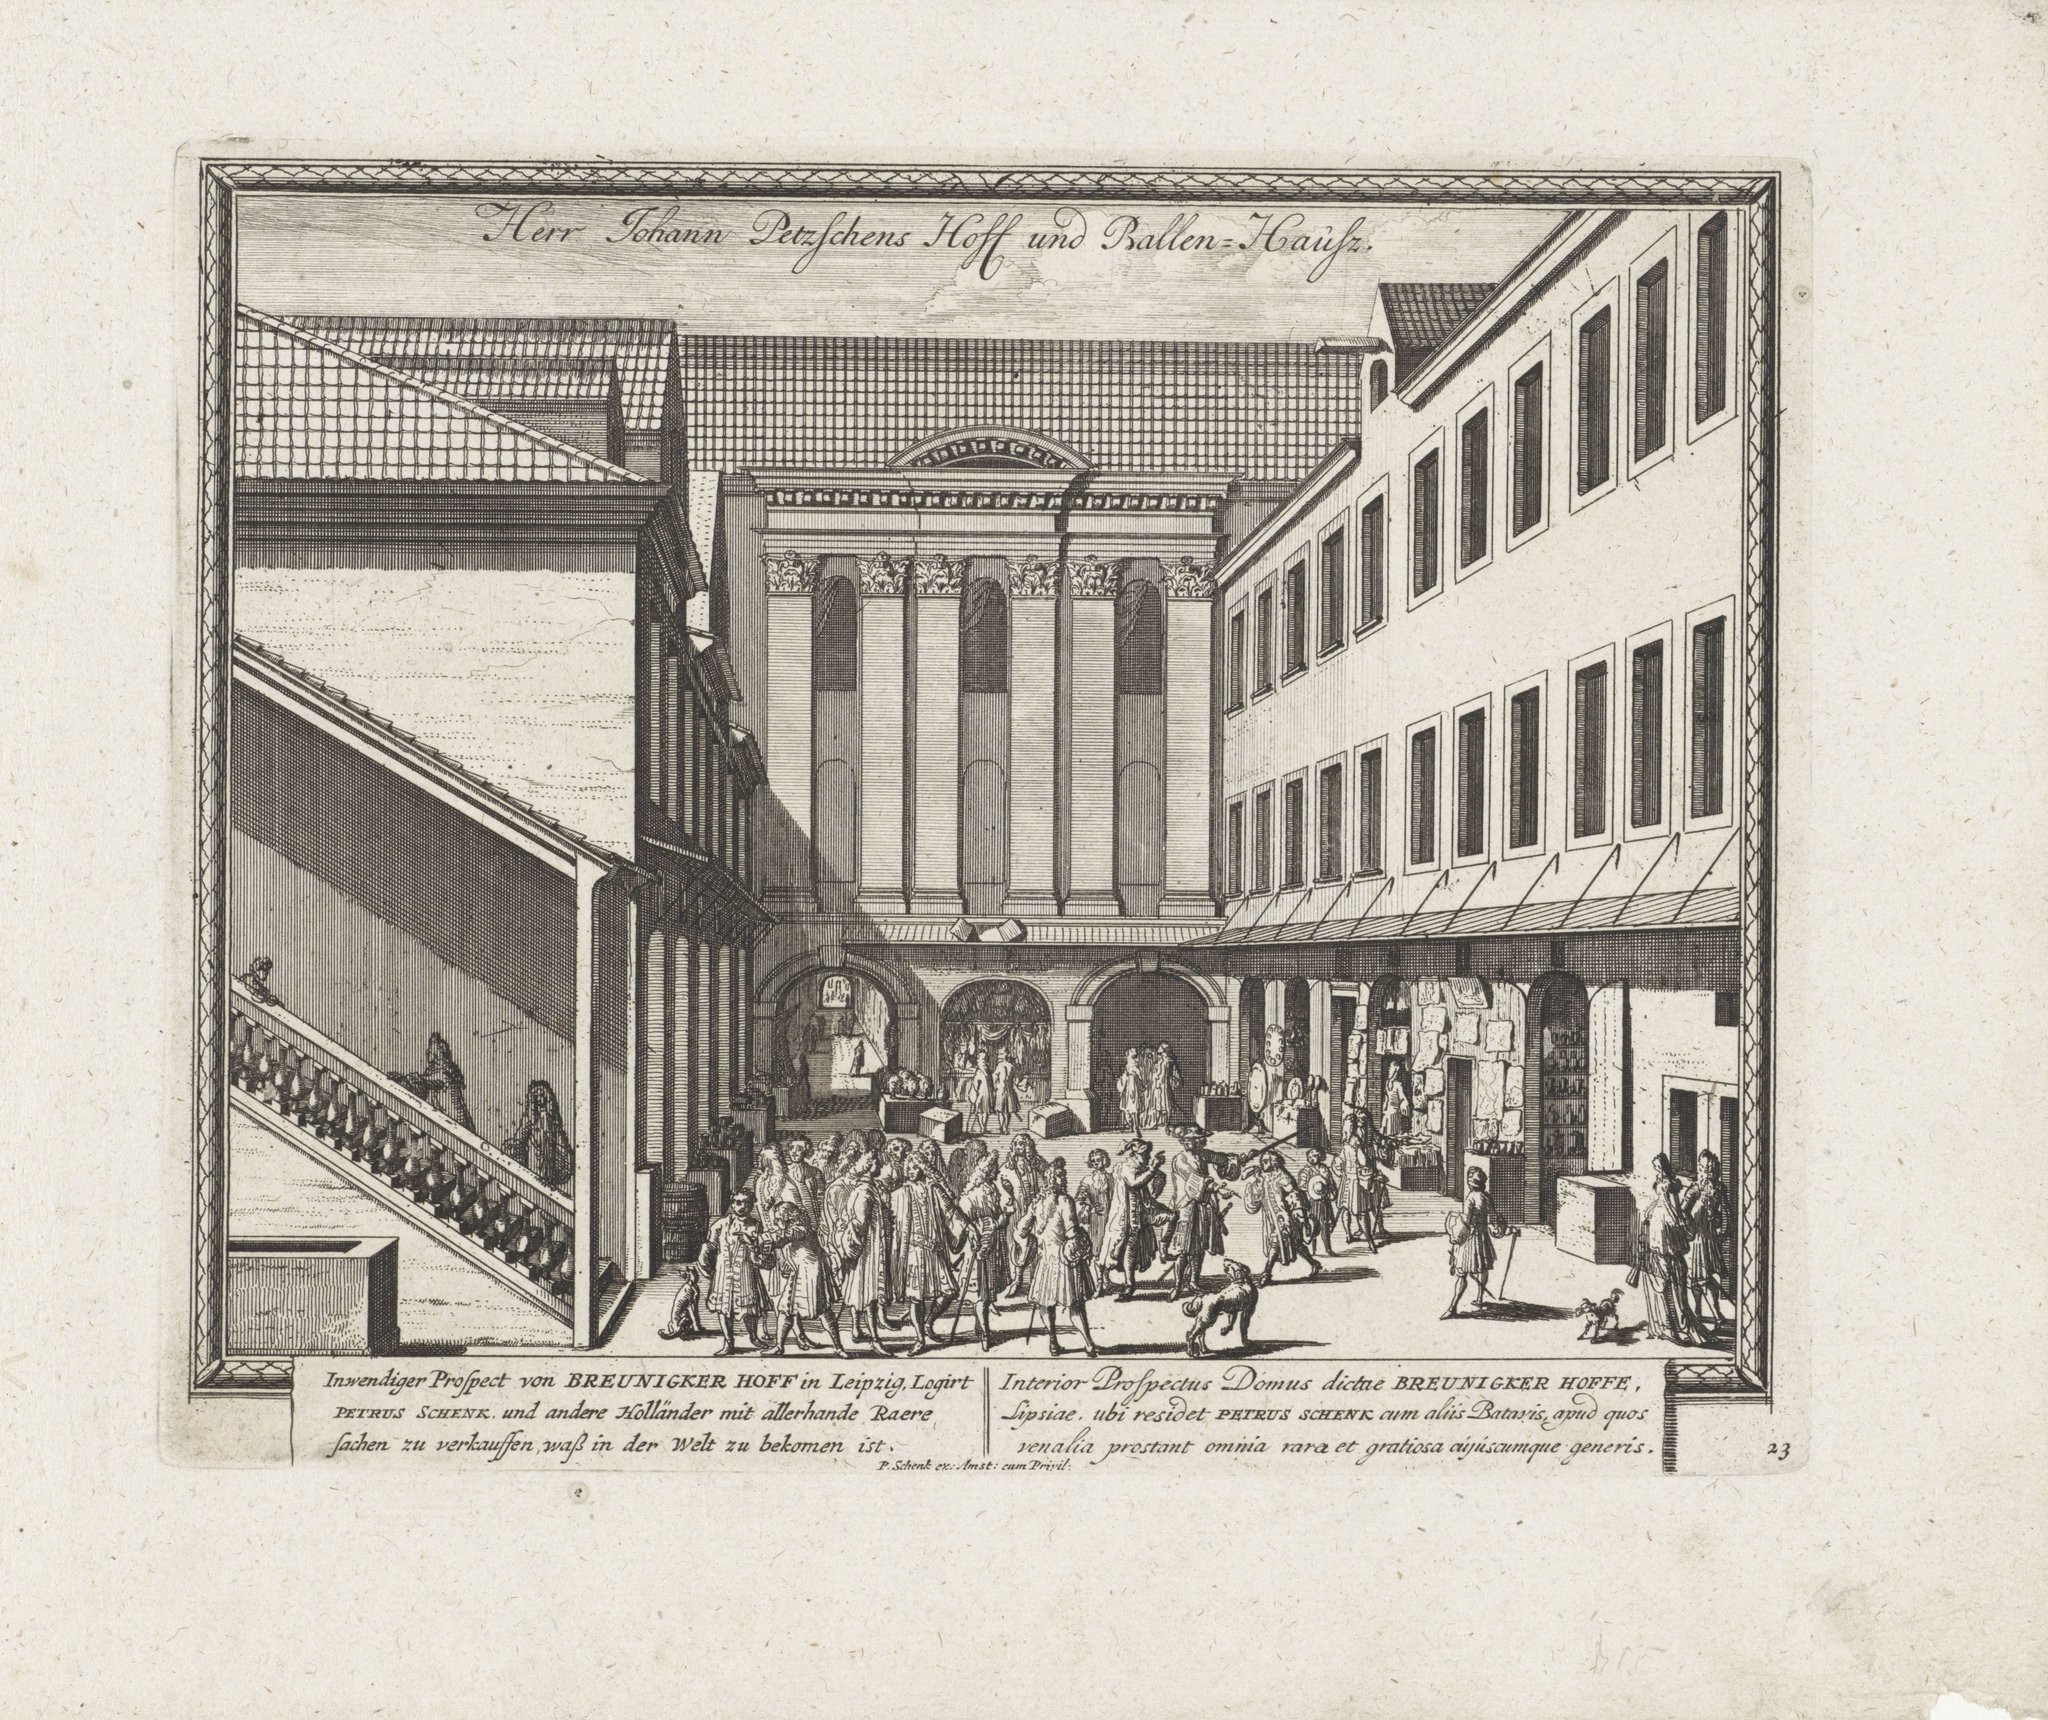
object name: print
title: Herr Johann Petzschens Hoff und Ballen = Hausz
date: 1675-1711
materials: paper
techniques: etching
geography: amsterdam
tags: shop, store, print, e.g.: engraving, etching, lithograph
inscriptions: collector's mark: Lugt 2228, collector's mark: Lugt 2760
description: Gezicht op de prentenwinkel van Pieter Schenk op de Leipziger Messe. Voor de winkel bevinden zich vele mensen en aan de gevel hangen verschillende prenten.